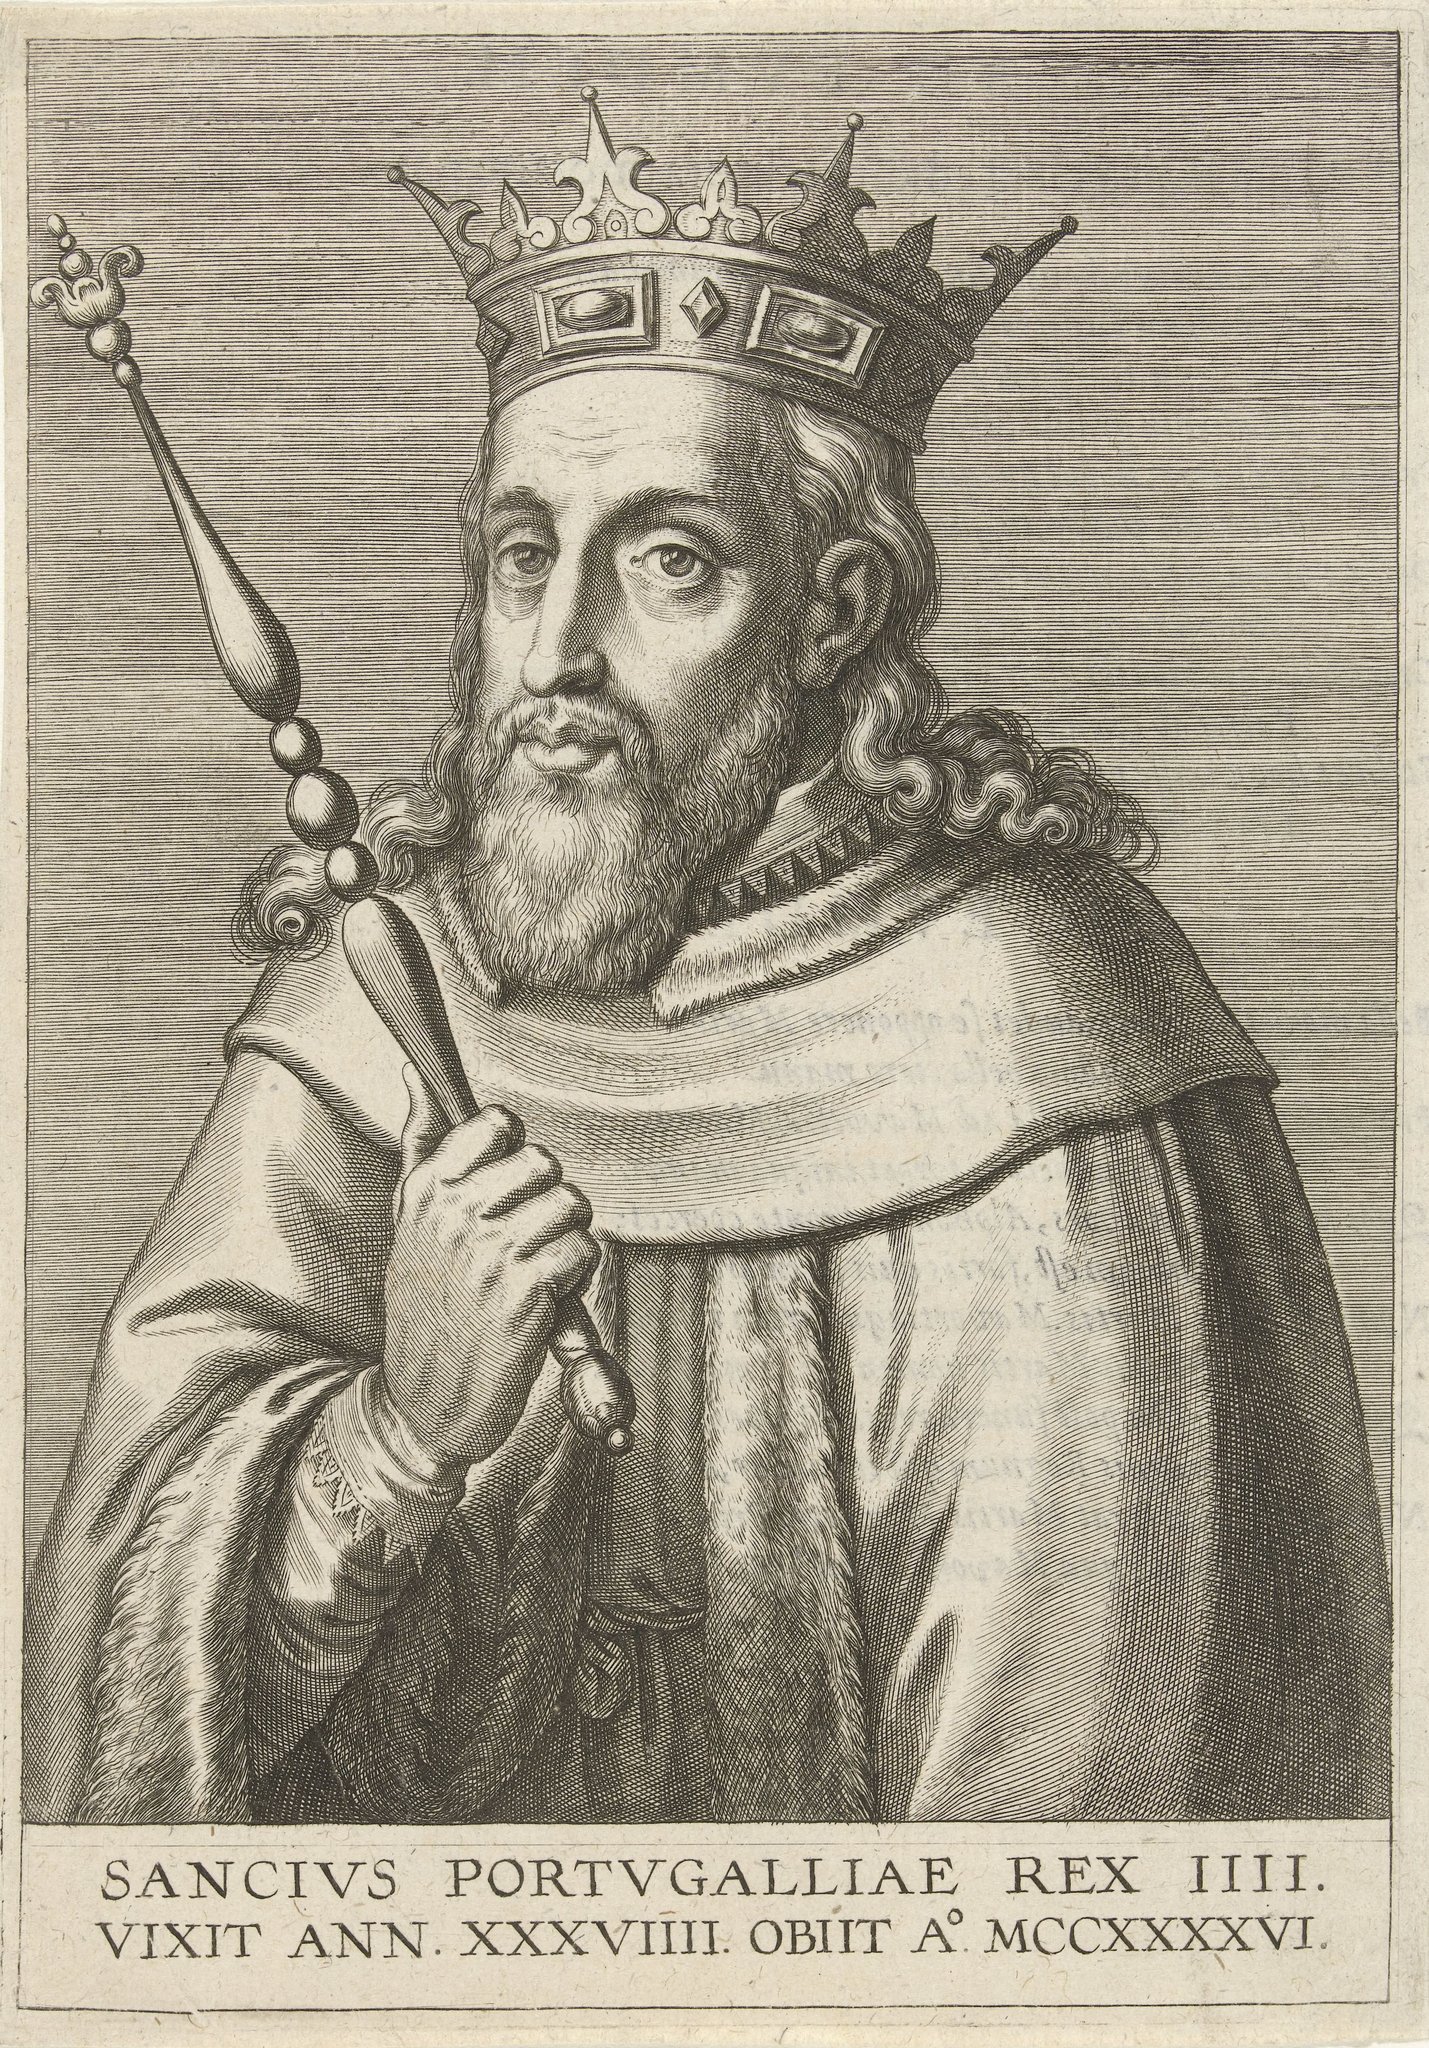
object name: book illustration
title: Koningen en prinsen van Portugal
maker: cornelis galle (i)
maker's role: print maker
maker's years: 1576-1650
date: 1621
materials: paper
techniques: engraving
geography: southern netherlands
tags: insignia and symbols of sovereignty (crown, diadem, sceptre, orb, seal, standard, cloak, pectoral)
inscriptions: collector's mark: Lugt 2228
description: Illustratie voor: Antonio Vasconcellos. Anacephalæoses id est, Svmma captia actorvm regvm Lvsitaniæ. Antwerpen: Petrus II en Joannes II Bellerus, 1621.